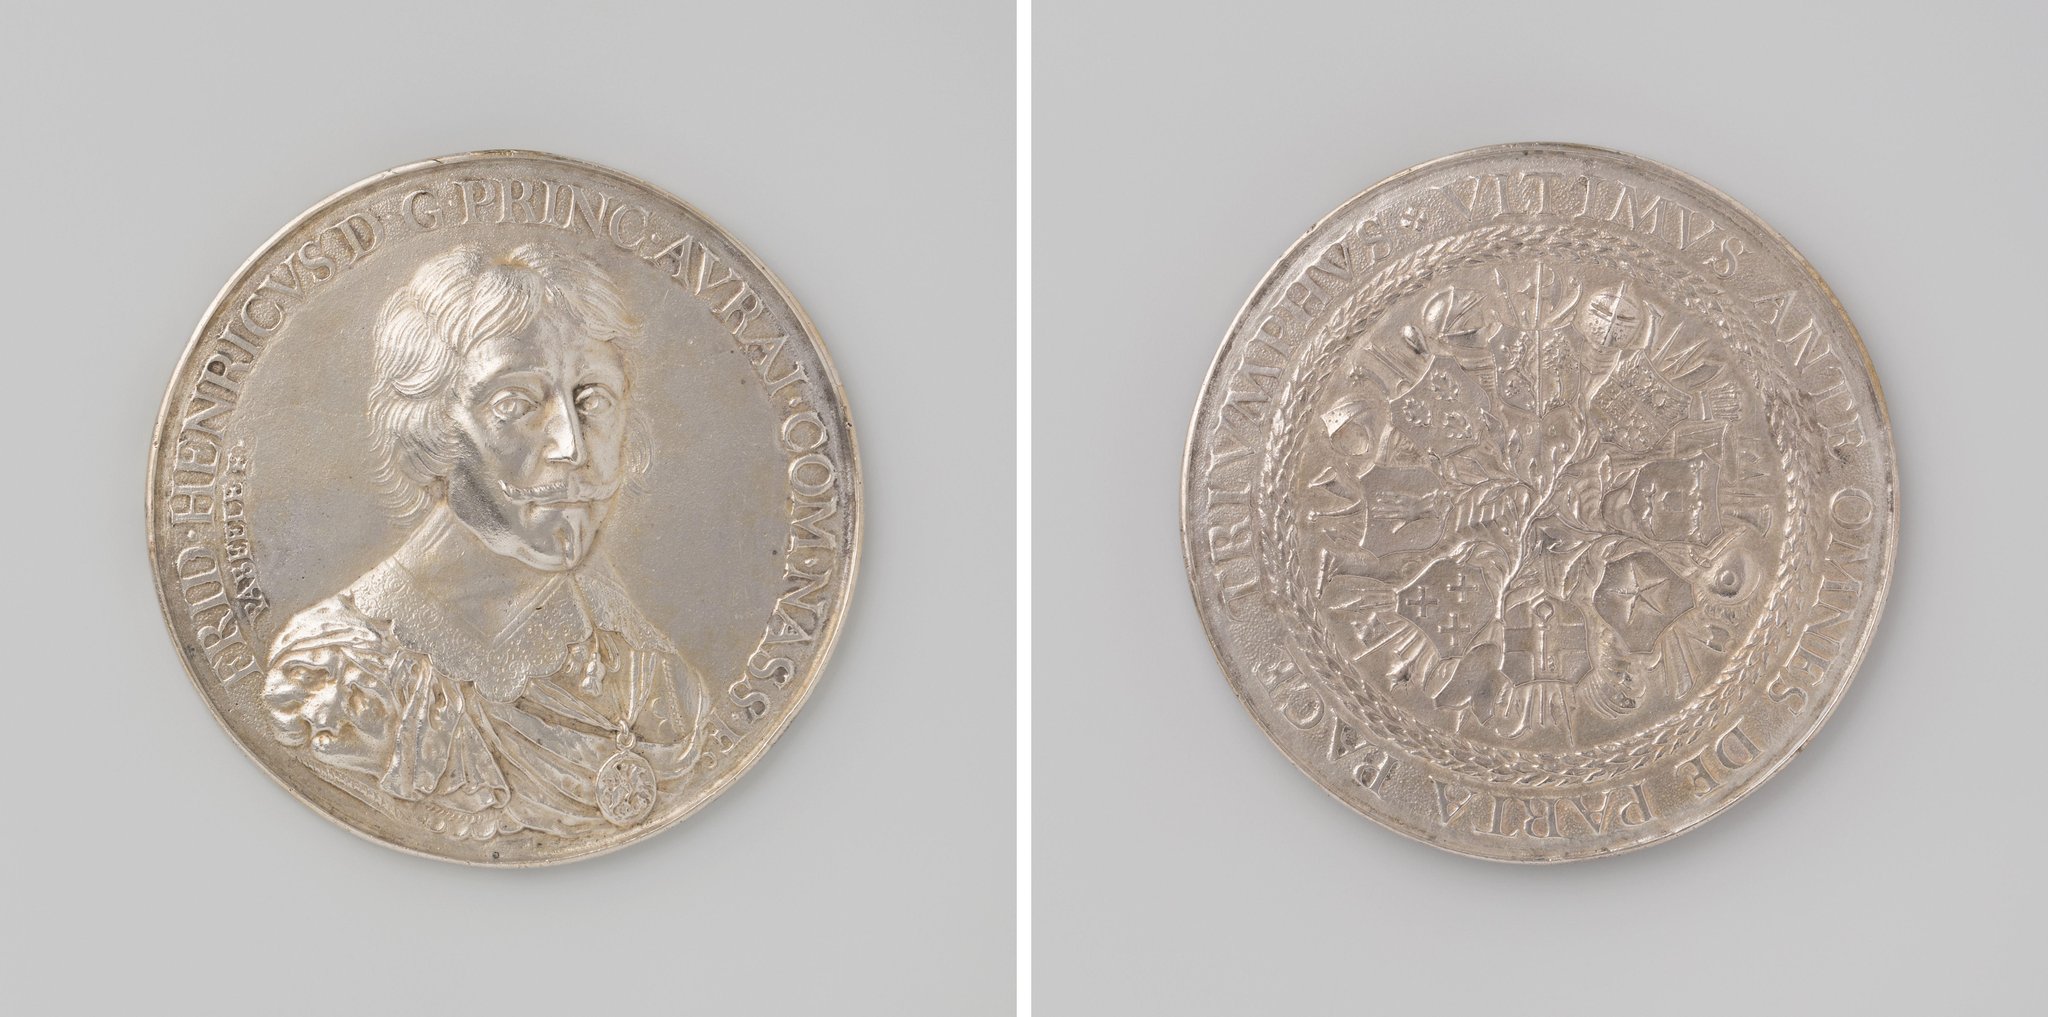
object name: honorary medal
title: Veroveren van acht steden en de vooruitzichten op vrede, ter ere van Frederik Hendrik, prins van Oranje-Nassau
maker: pieter van abeele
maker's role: draughtsman, jeweler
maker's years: 1608-1684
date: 1654-1658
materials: silver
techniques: casting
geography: amsterdam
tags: delft, the hague, frederick henry (prince of orange)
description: Zilveren penning. Voorzijde: borststuk man binnen omschrift. Keerzijde: trophee, opgebouwd uit acht wapenschilden, bladranken en wapentuig binnen lauwerkrans en omschrift.